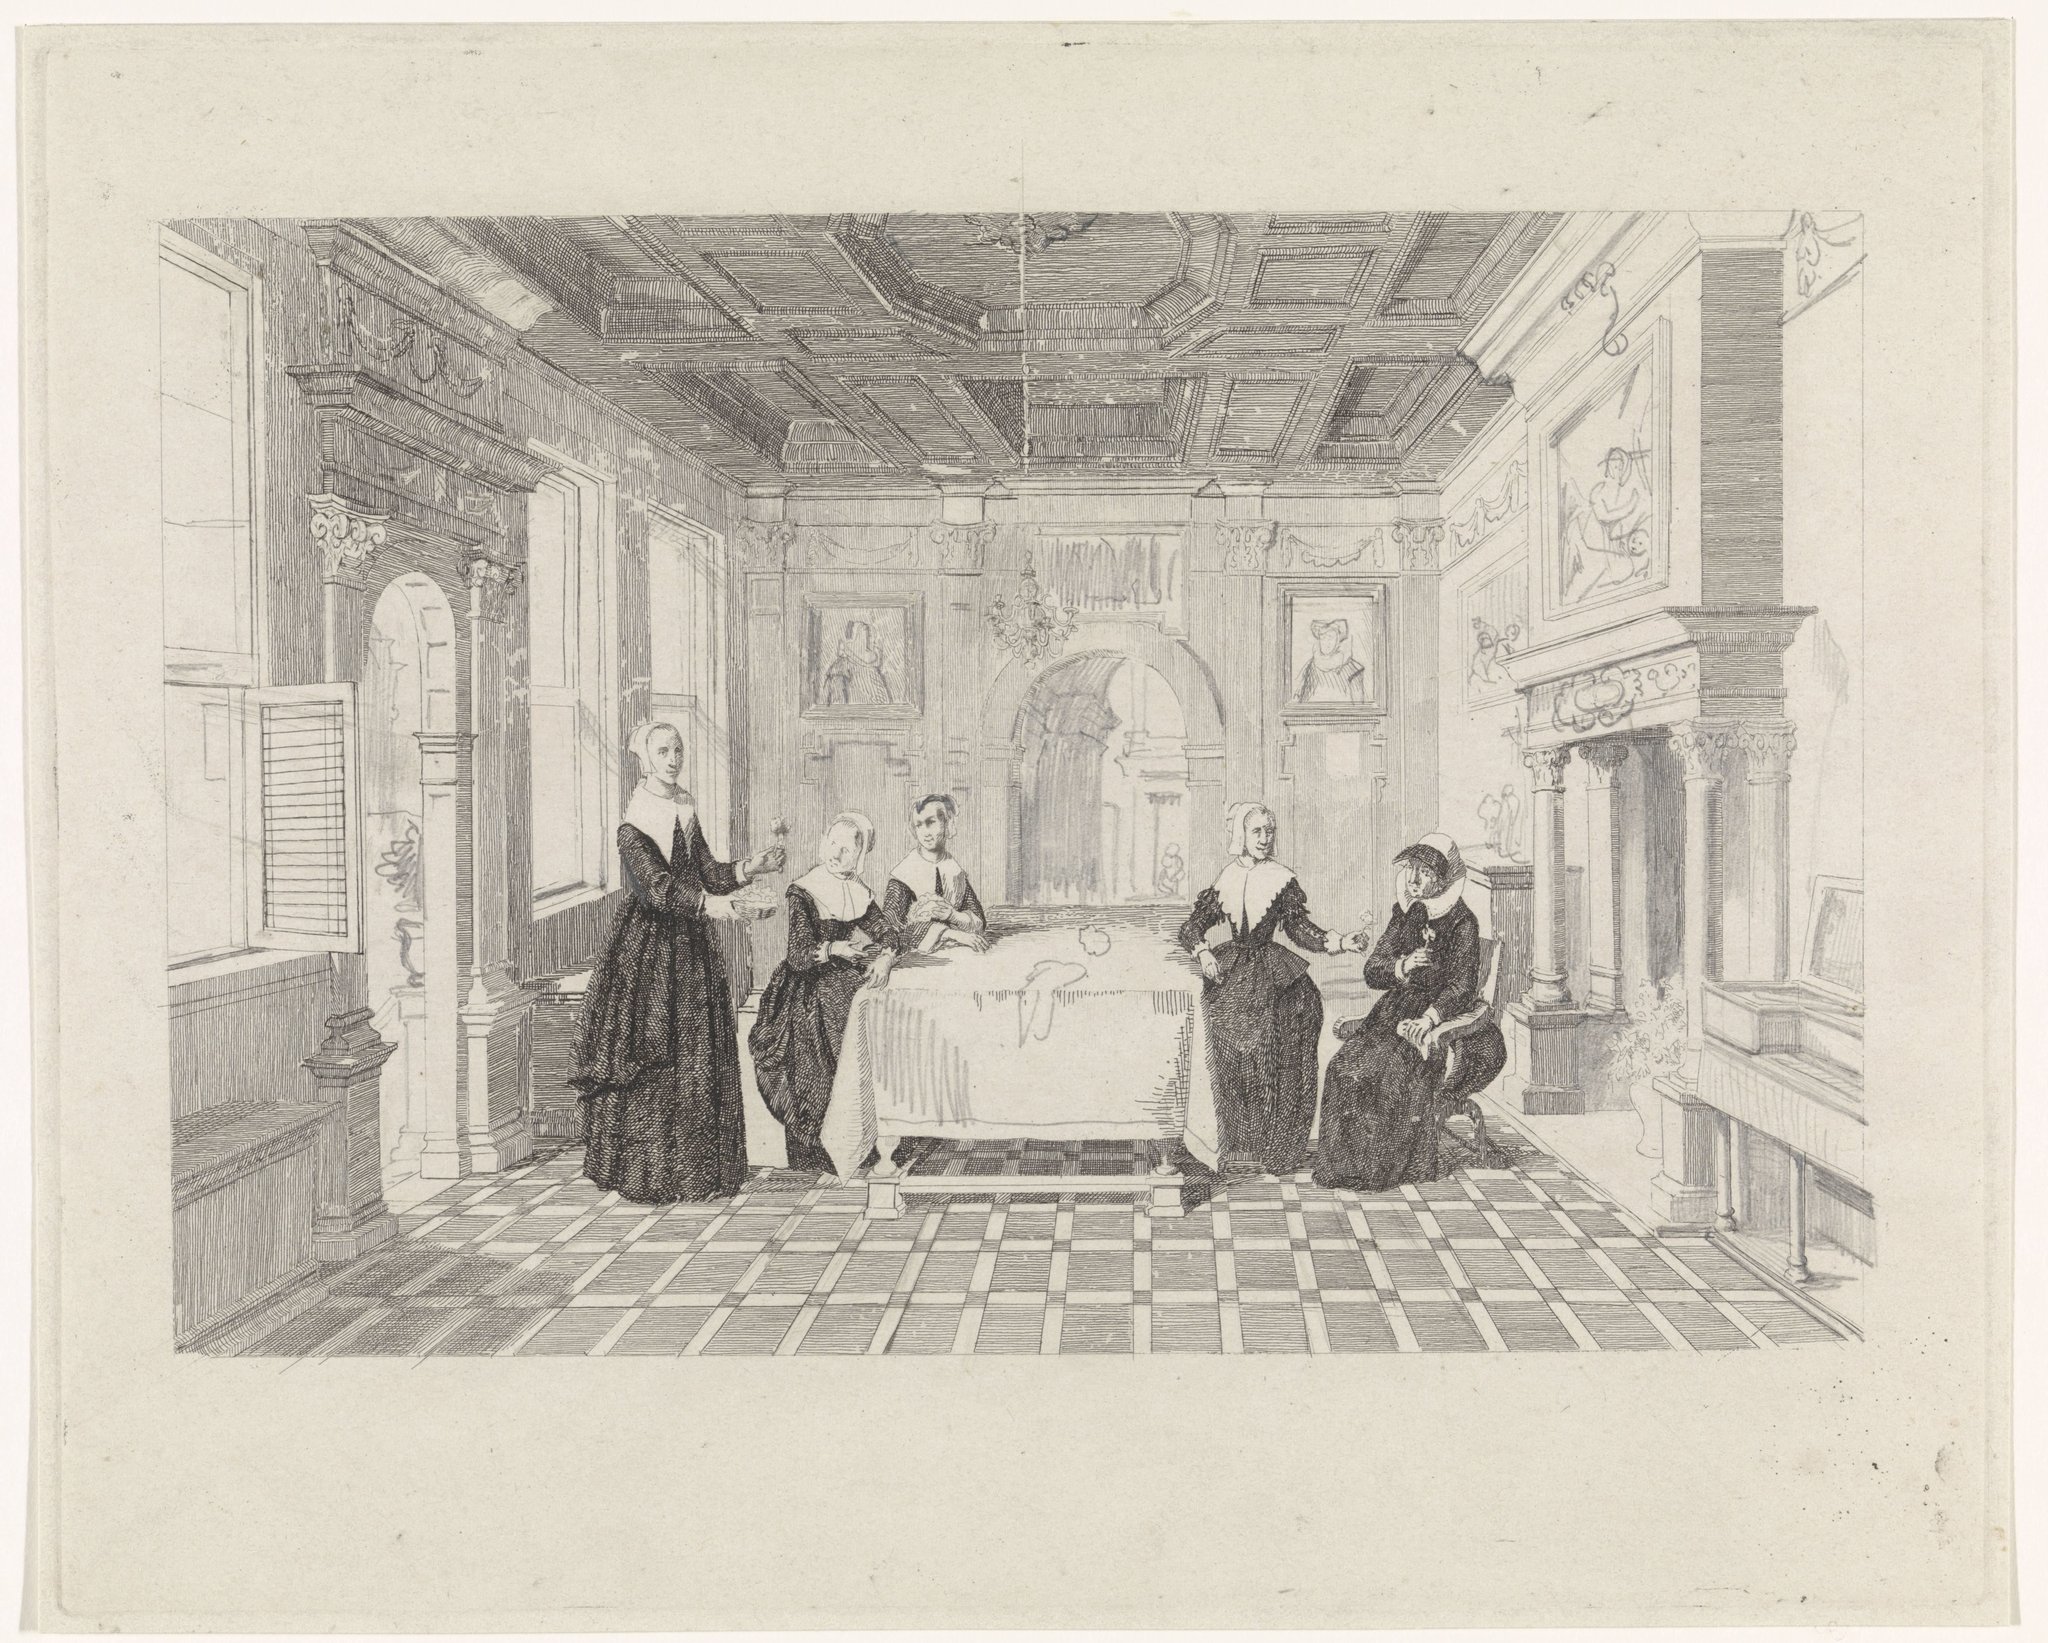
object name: print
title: Vrouwen met bloemen in een vertrek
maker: david van der kellen (1827-1895)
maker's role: draughtsman, print maker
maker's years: 1827-1895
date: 1837-1883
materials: paper, pencil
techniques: etching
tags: adult woman (+ number of persons), decorations (interior of the house), cut flowers; nosegay, bunch of flowers, picture, painting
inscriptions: collector's mark: Lugt 2228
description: In een rijk gedecoreerd vertrek, met een ornamentele schouw waar een vaas met bloemen in staat, bevindt zich een vijftal vrouwen in zeventiende-eeuwse kleding. Vier vrouwen zitten aan tafel terwijl de vijfde al staande een bloem toont aan de anderen, die ook bloemen bij zich hebben. Boven de schouw hangt een schilderij met een bijbelse voorstelling en naast de doorgang achter de tafel hangen twee portretten; één van een man en één van een vrouw.